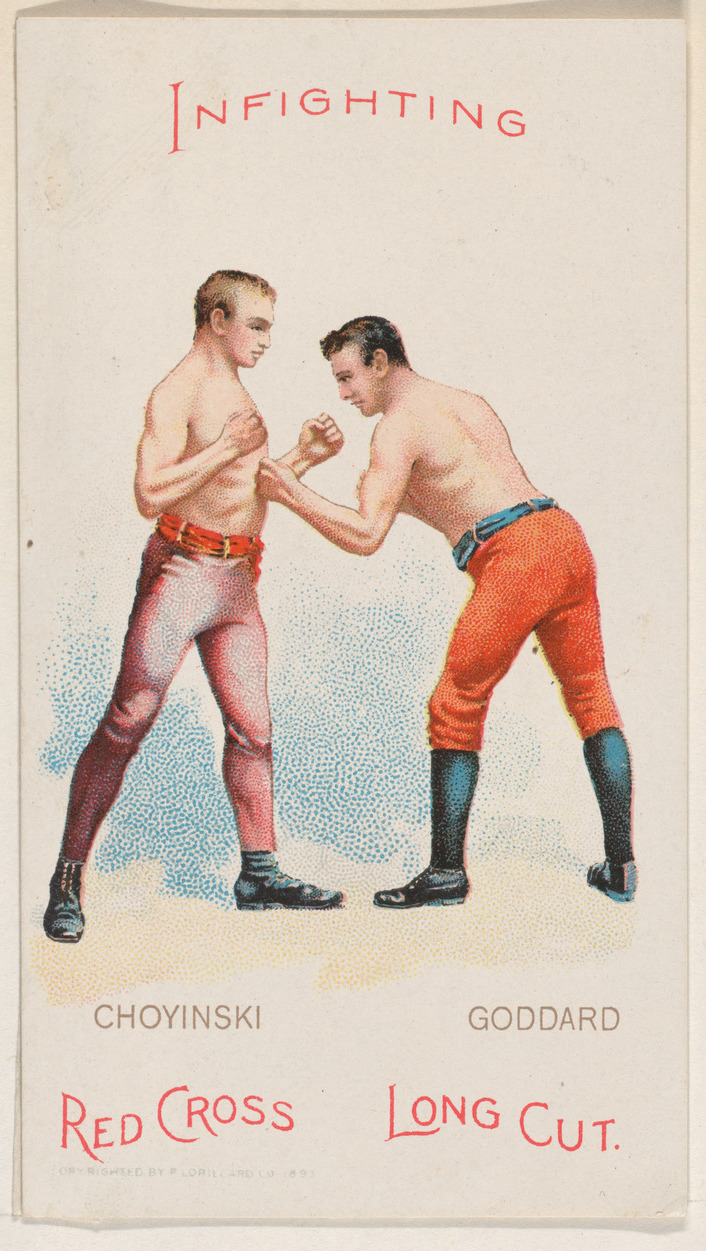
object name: print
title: Infighting, Joe Goddard and Joe Chovinski, from the Boxing Positions and Boxers series (N266) issued by P. Lorillard Company to promote Red Cross Long Cut Tobacco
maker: p. lorillard company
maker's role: publisher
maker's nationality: american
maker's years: 1760-2014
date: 1893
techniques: color lithograph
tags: men,boxing,athletes